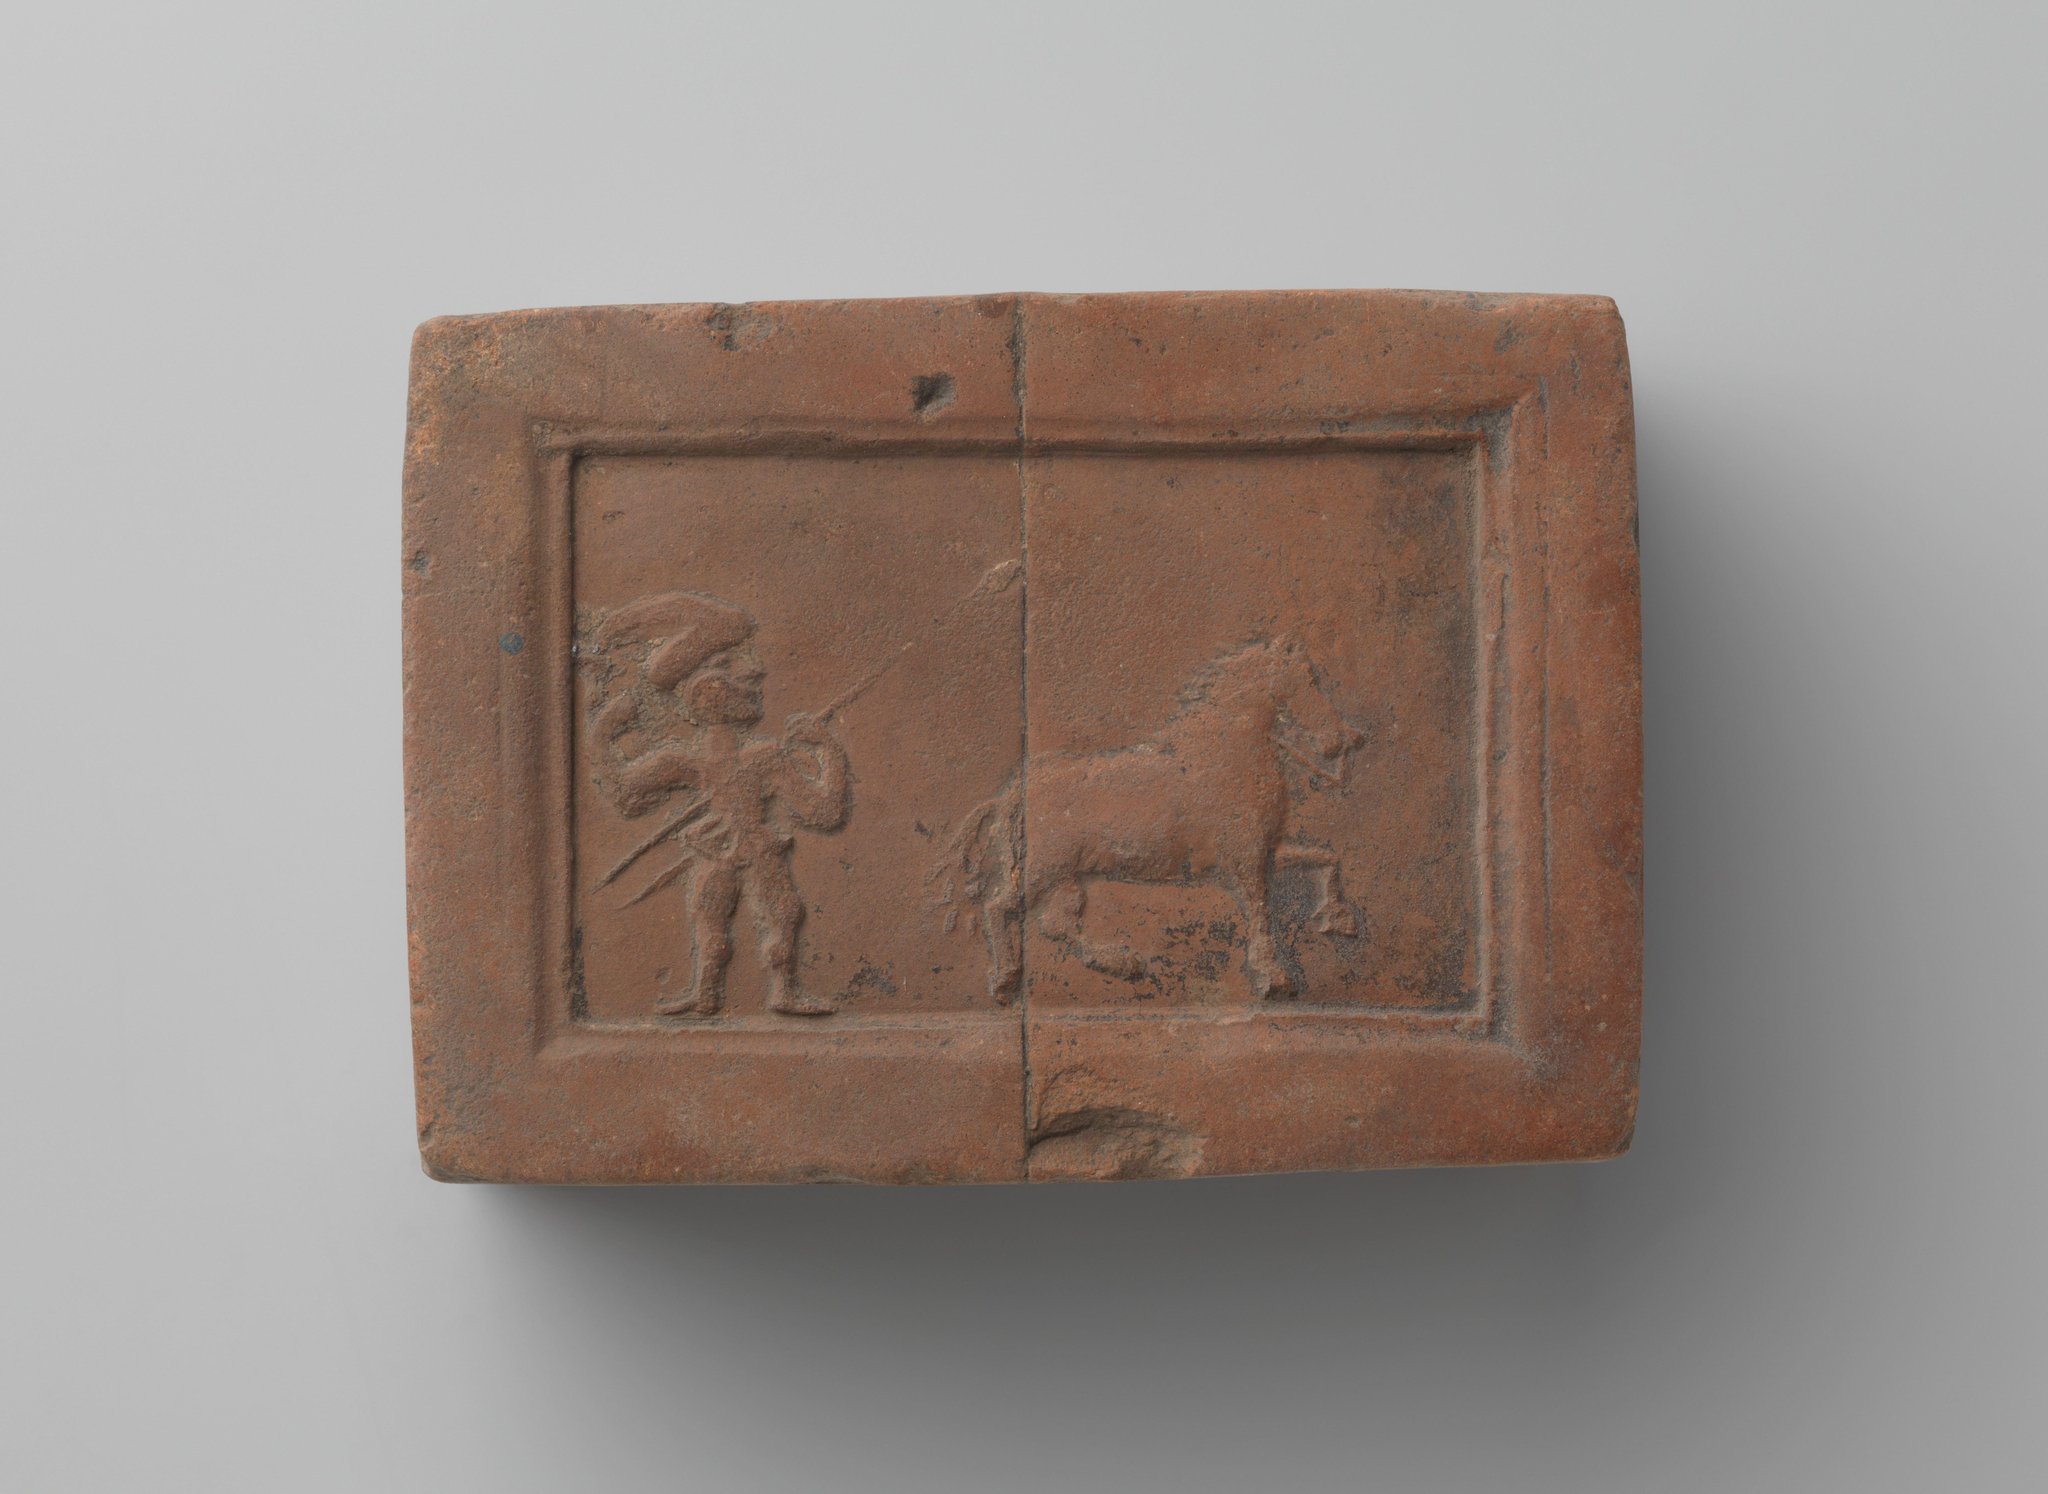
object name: hearthstone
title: Haardsteen met voorstelling van een man met speer en paard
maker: Anonymous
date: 1550-1600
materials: earthenware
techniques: printing, firing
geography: southern netherlands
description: Haardsteen met voorstelling van een man met speer en paard.